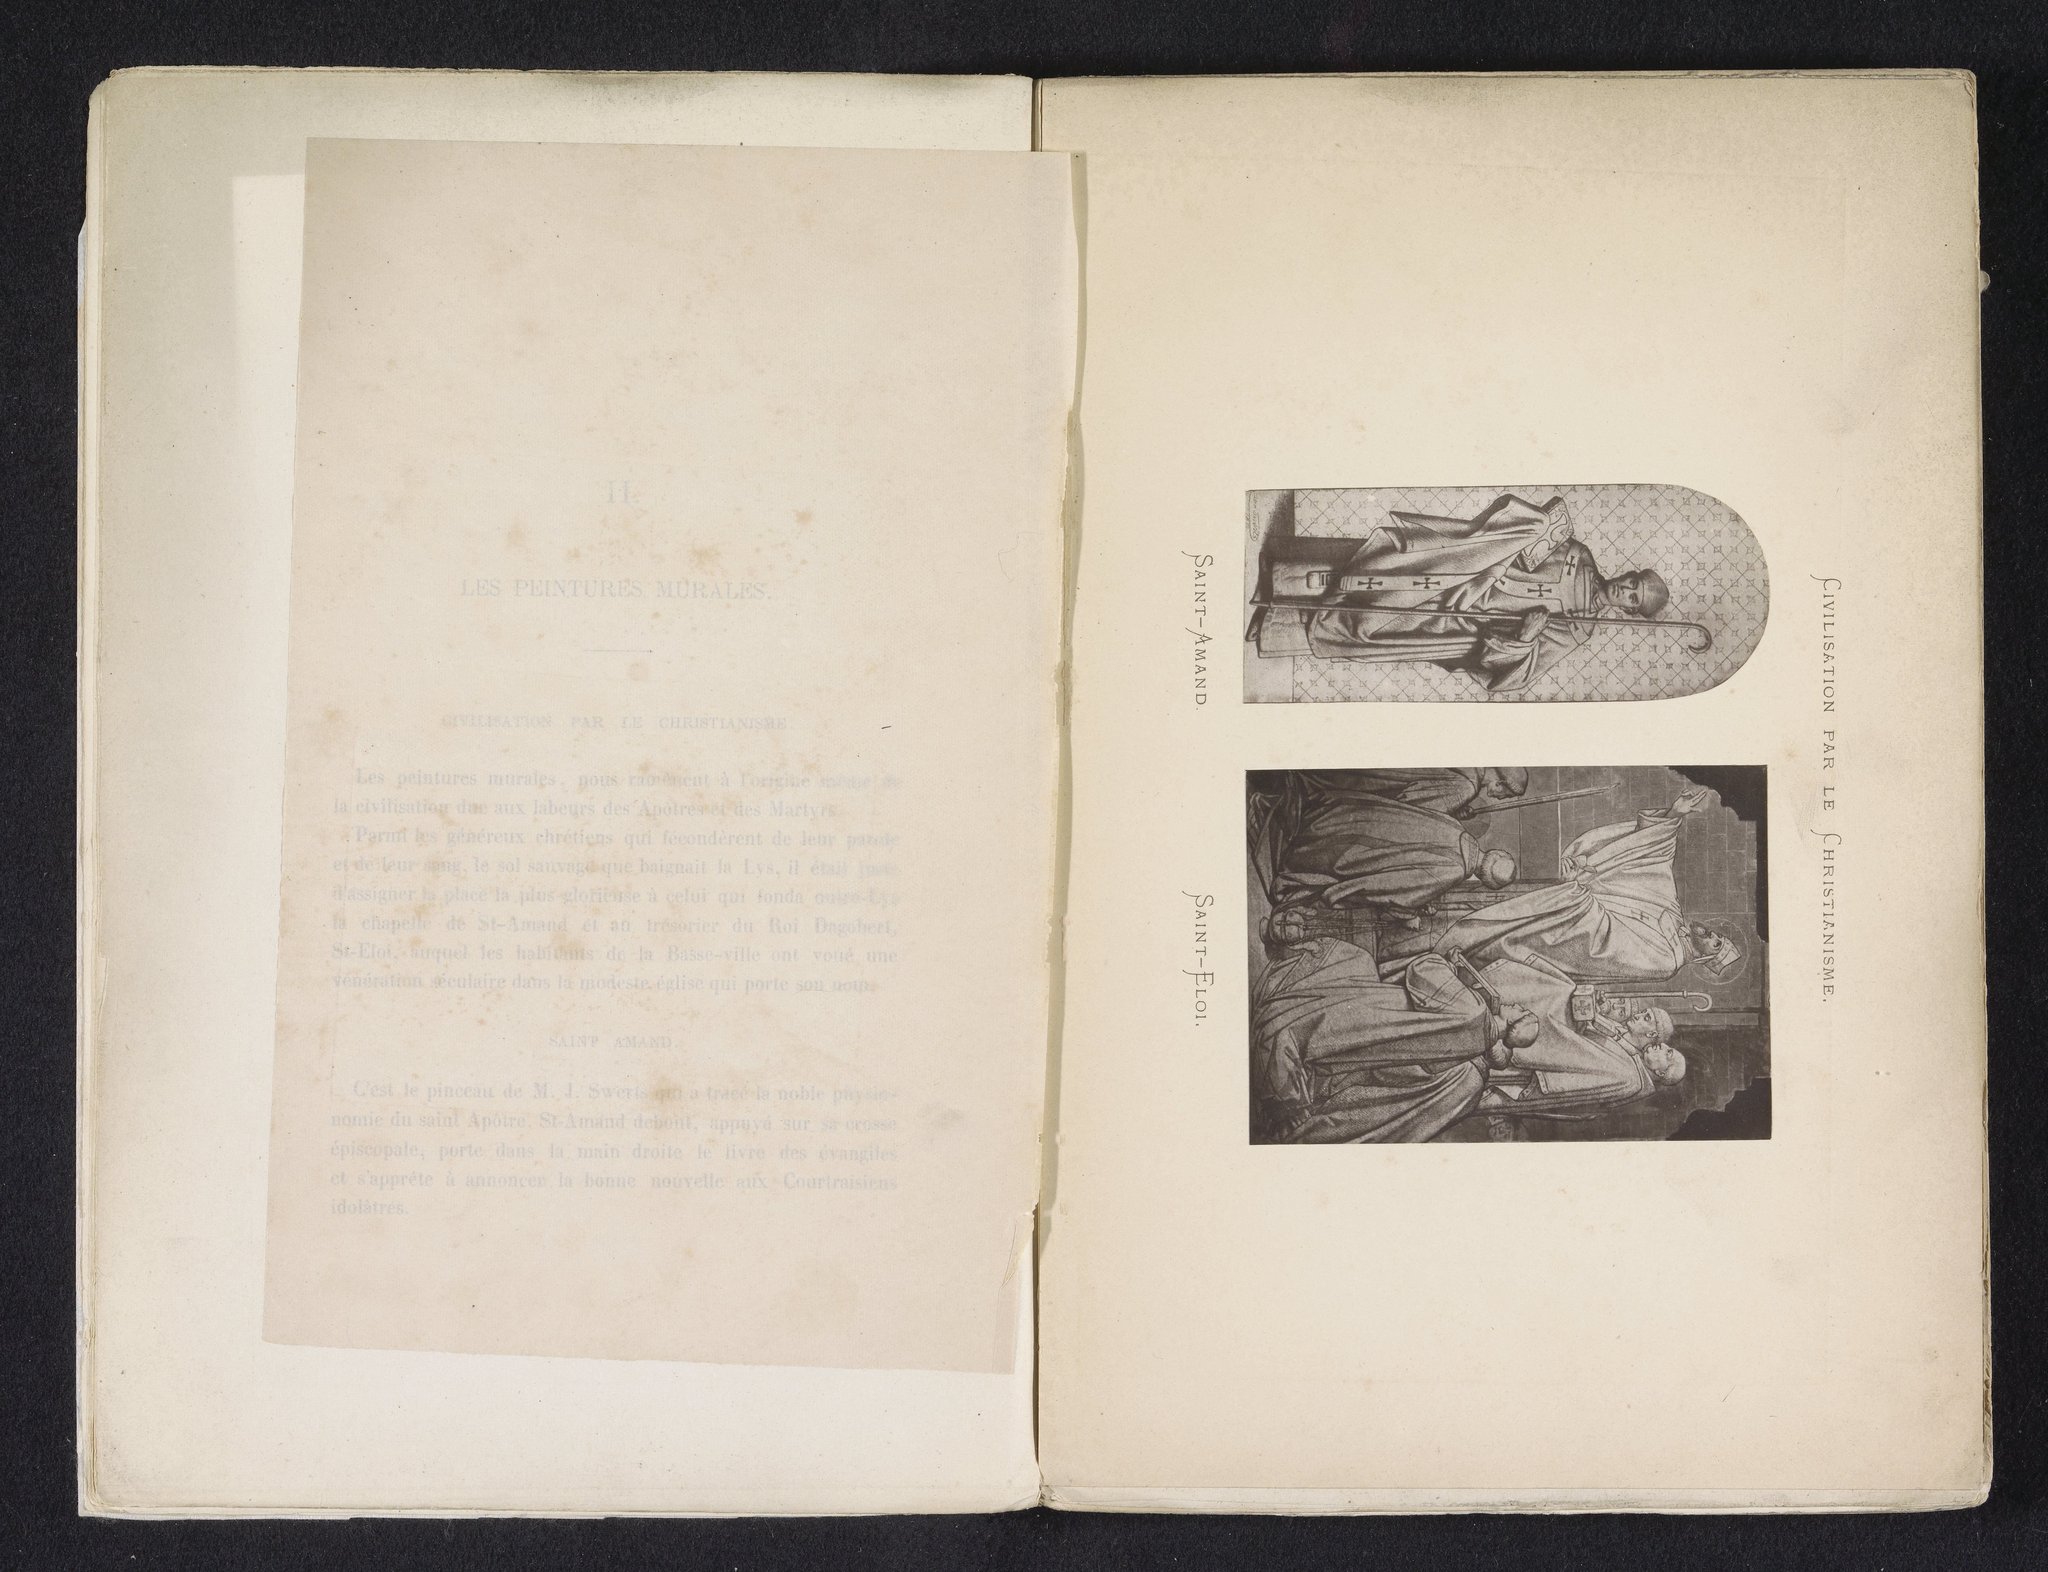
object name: reproduction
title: Fotoreproducties van twee tekeningen naar muurschilderingen in de Schepenzaal in het Stadhuis van Kortrijk, voorstellende de heilige Amandus en de heilige Eligius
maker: Anonymous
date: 1866-1876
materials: cardboard, paper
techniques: woodburytype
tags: the blacksmith and goldsmith eloi (eligius), bishop of noyon; possible attributes: anvil, cup, (crown on) hammer, horse (missing one leg), horseleg, horseshoe, tongs, amand(us) of maastricht; possible attributes: snake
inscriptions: inscription: ‘Civilisation par le christianisme.’